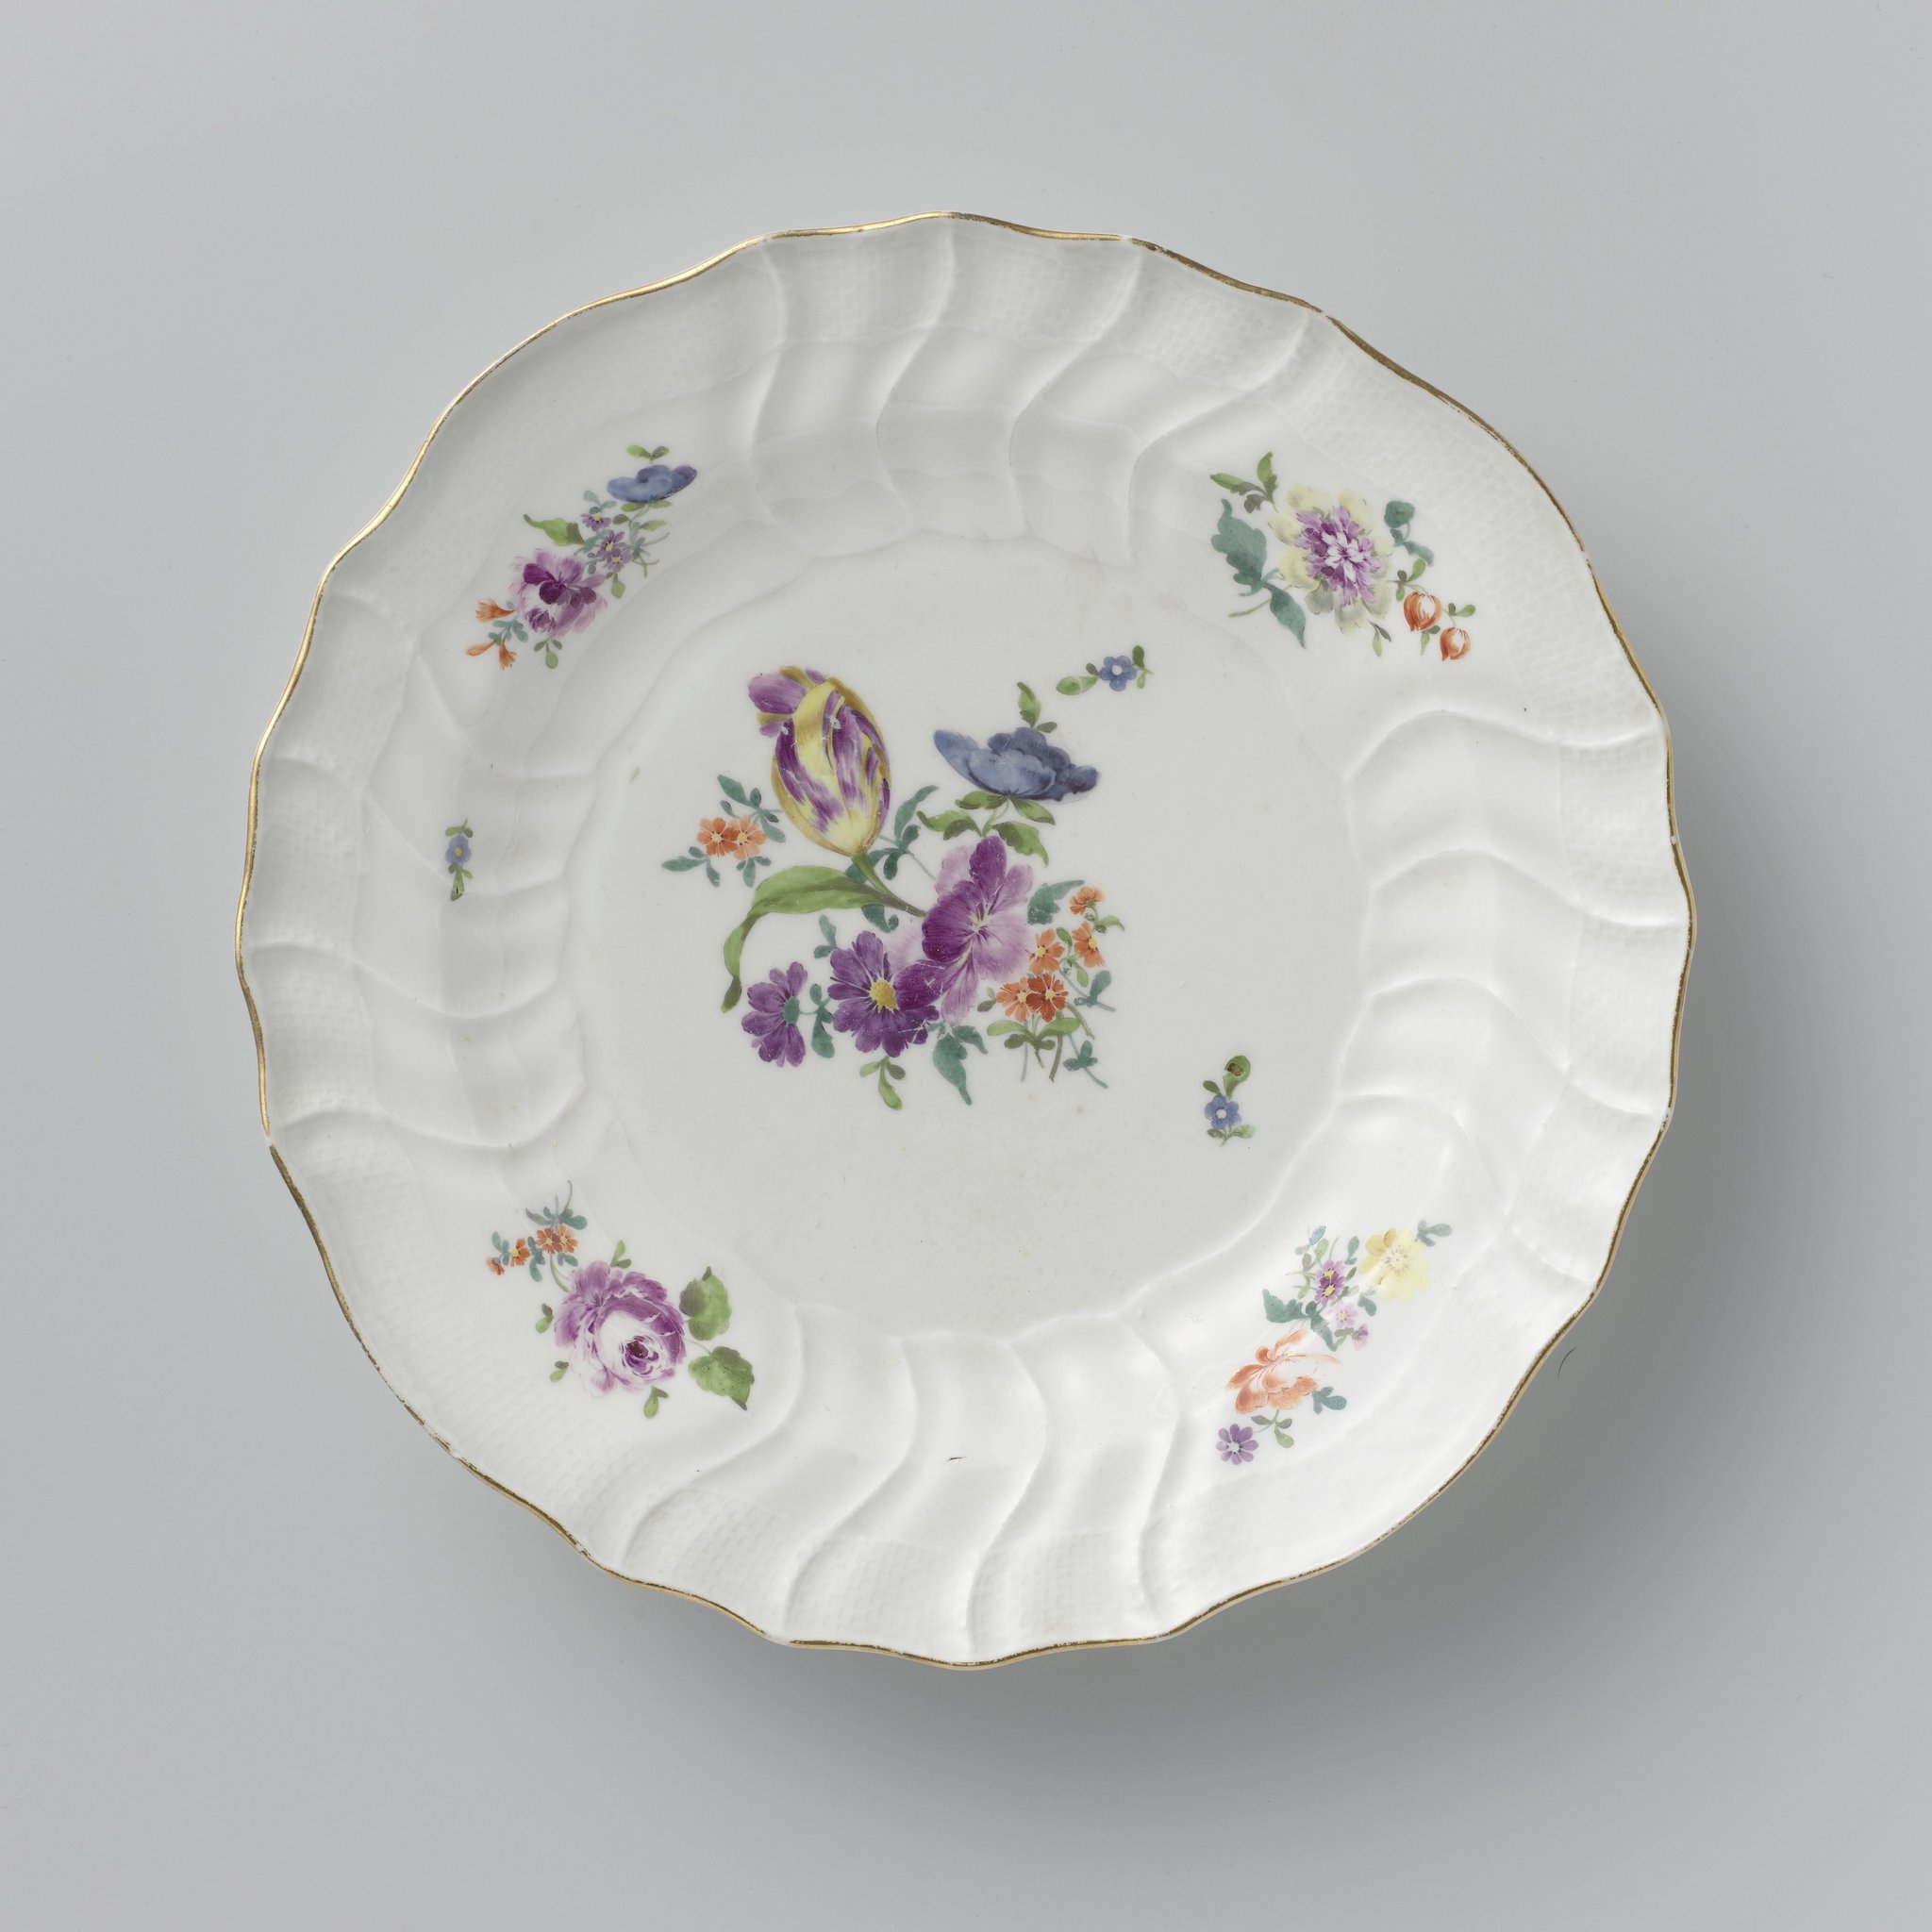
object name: plate dish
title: Bord, veelkleurig beschilderd met Deutsche Blumen, insekten en vruchten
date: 1750-1760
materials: porcelain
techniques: painted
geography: meissen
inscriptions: factory mark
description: Rond bord van beschilderd porselein. Het bord is beschilderd met Deutsche Blumen, insekten en vruchten. De rand is in reliëf versierd met het Neuozier-patroon. Het bord is gemerkt en hoort bij een servies (BK-17474-1 t/m BK-17474-253).